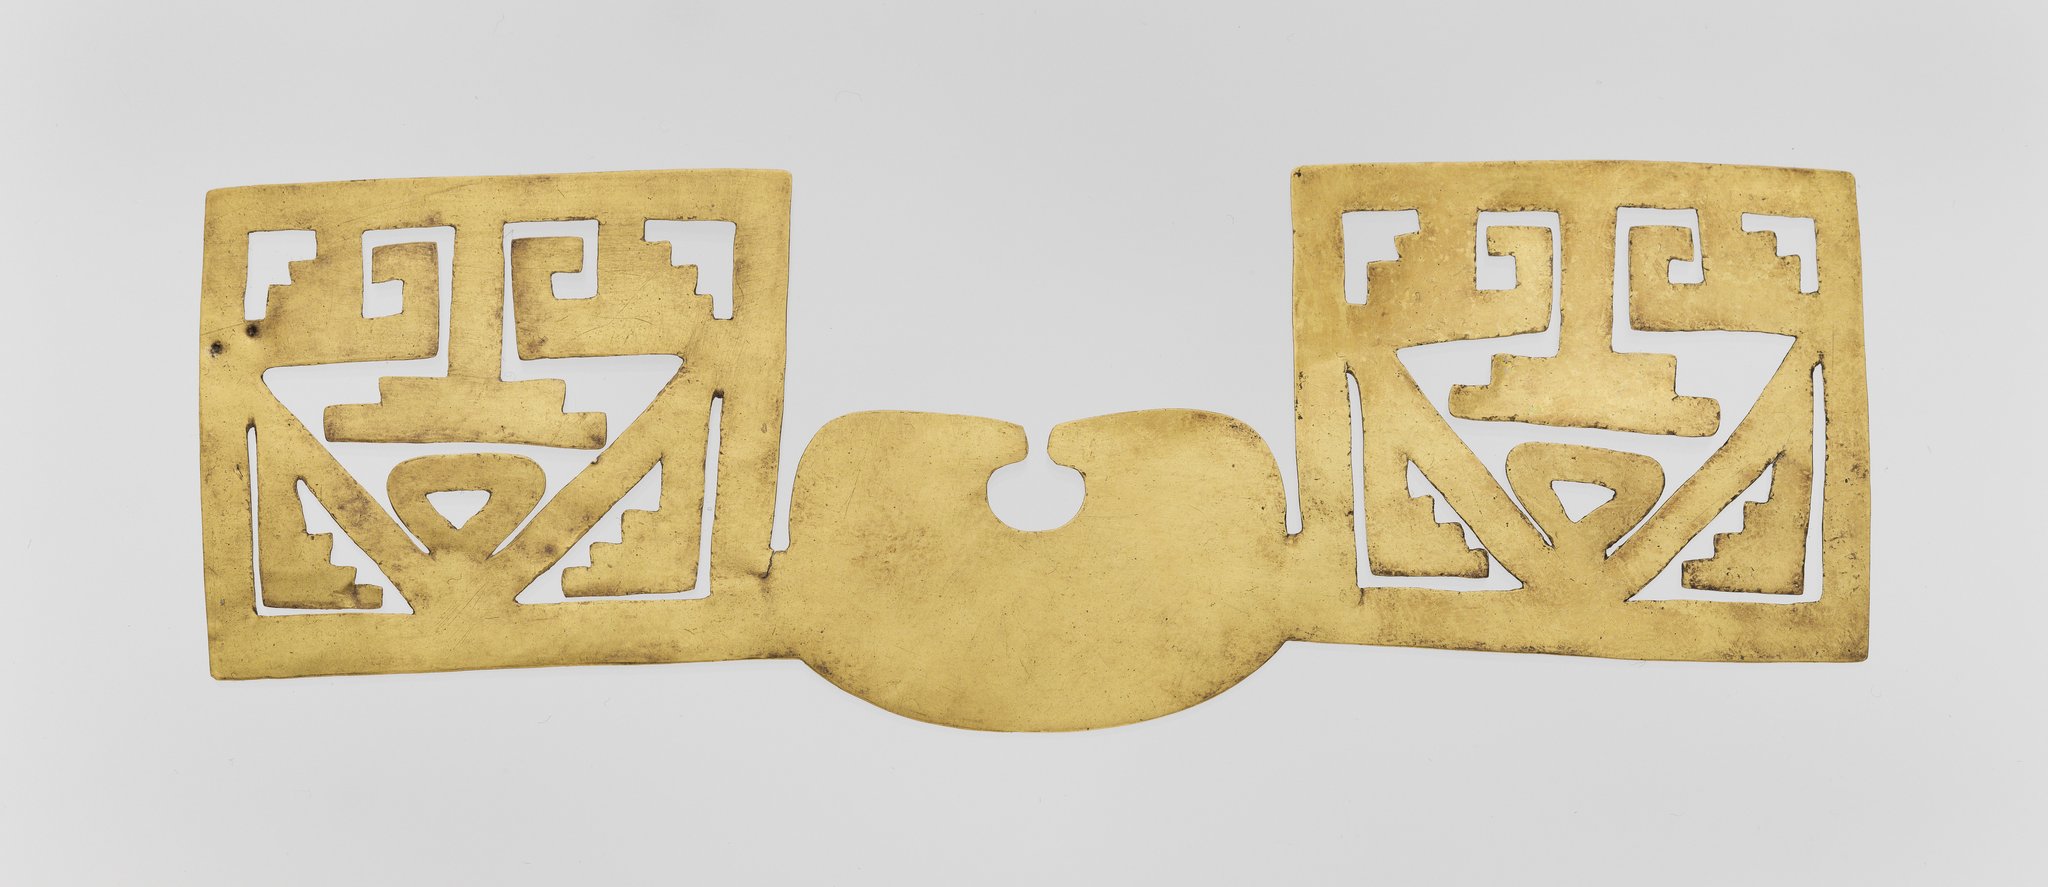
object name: nose ornament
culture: piartal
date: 601-1200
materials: gold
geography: colombia